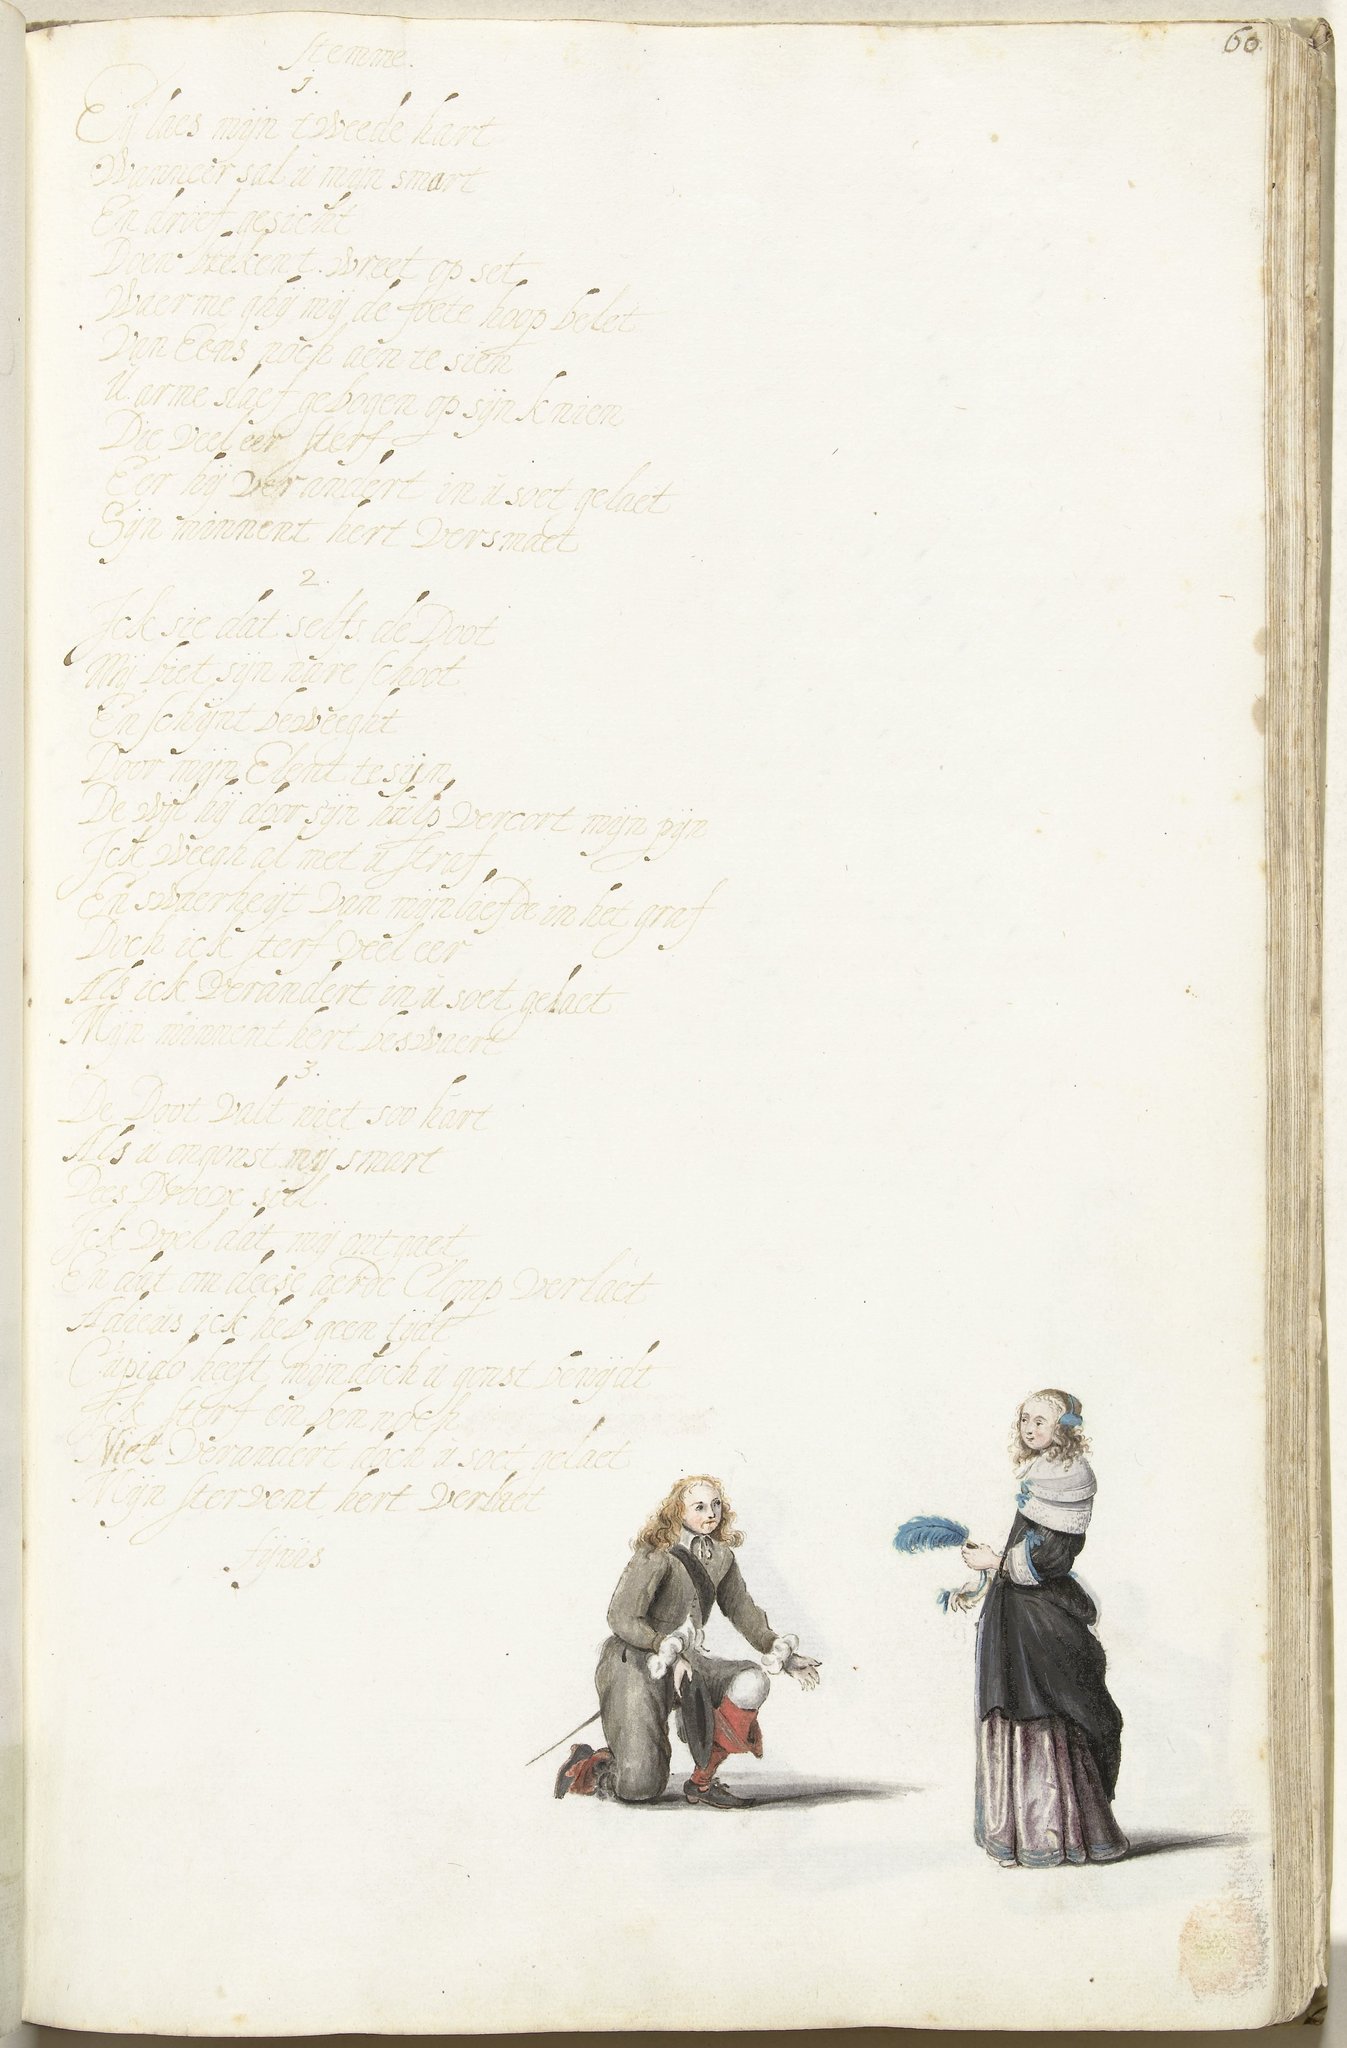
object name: poem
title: Heer knielend voor een dame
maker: gesina ter borch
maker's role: draughtsman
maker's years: 1633-1690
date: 1654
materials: ink, paper, watercolor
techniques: brush, calligraphy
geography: zwolle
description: Heer knielend voor een dame naast een liefdesklacht zonder aangegeven melodie.